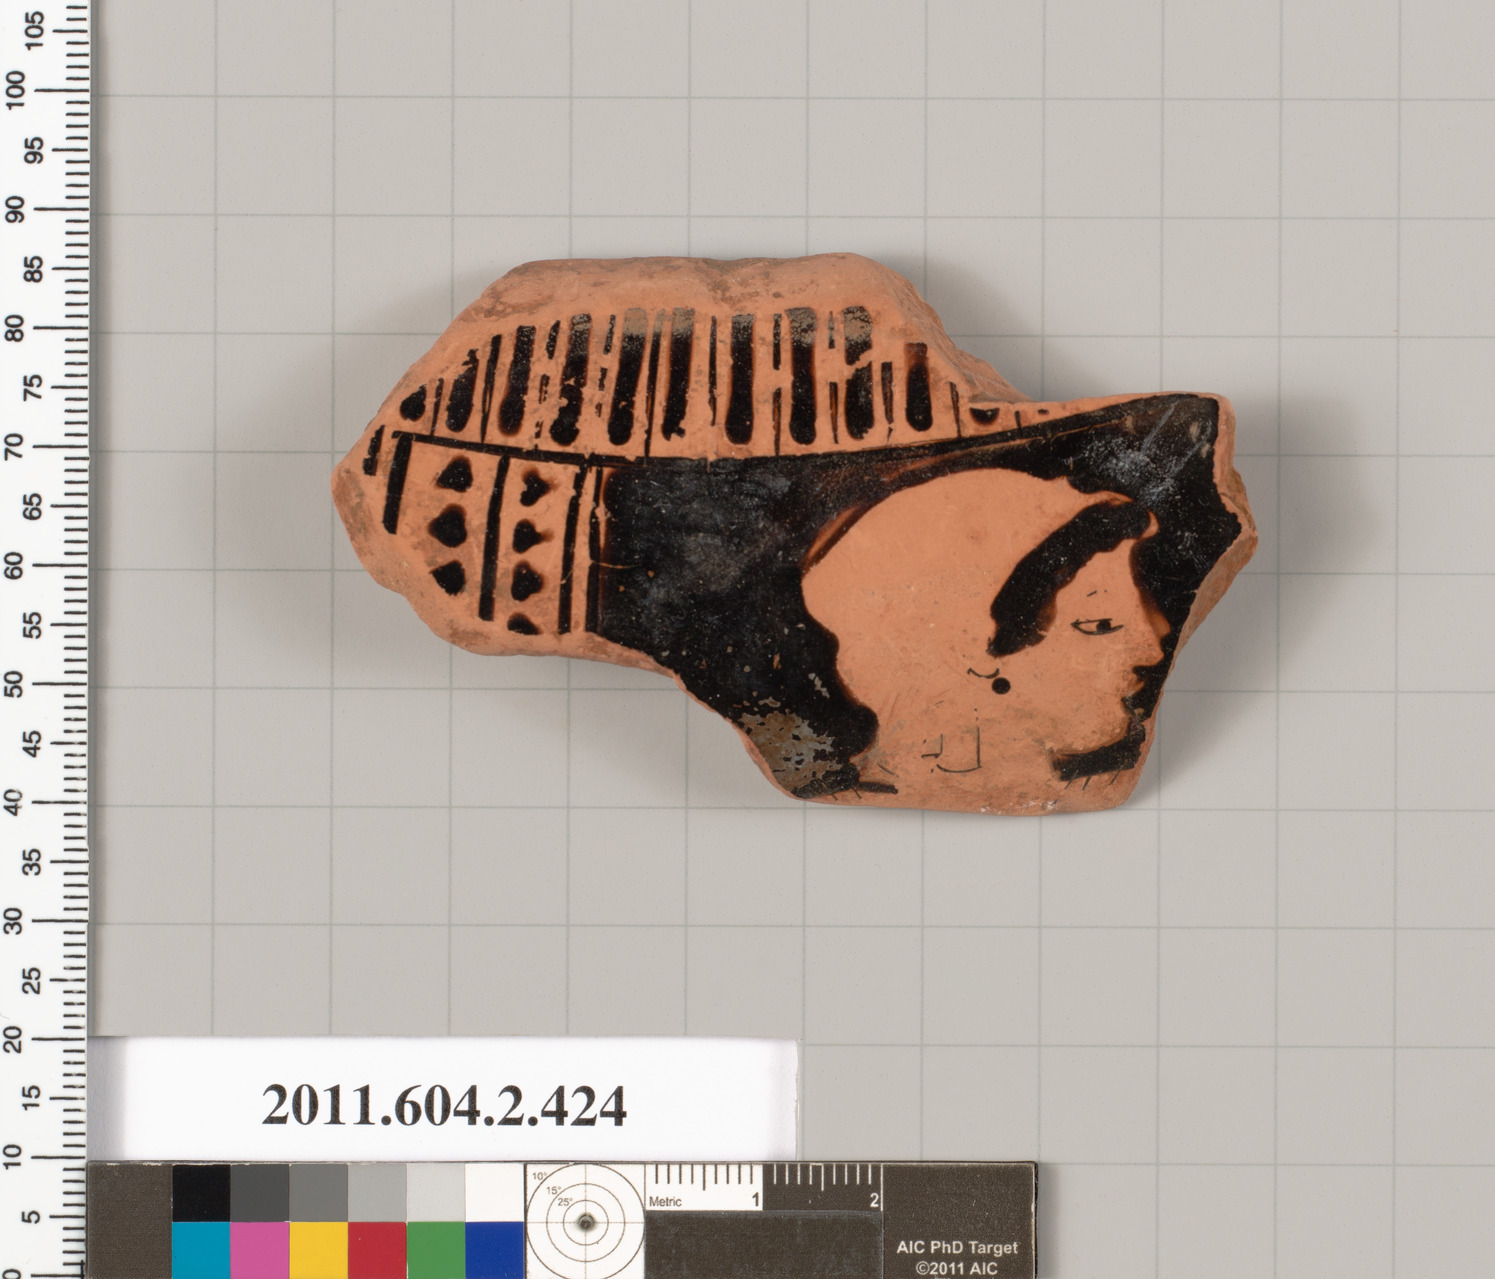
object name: column krater fragment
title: Terracotta fragment of a column-krater (bowl for mixing wine and water)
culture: greek, attic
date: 460-440 BCE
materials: terracotta